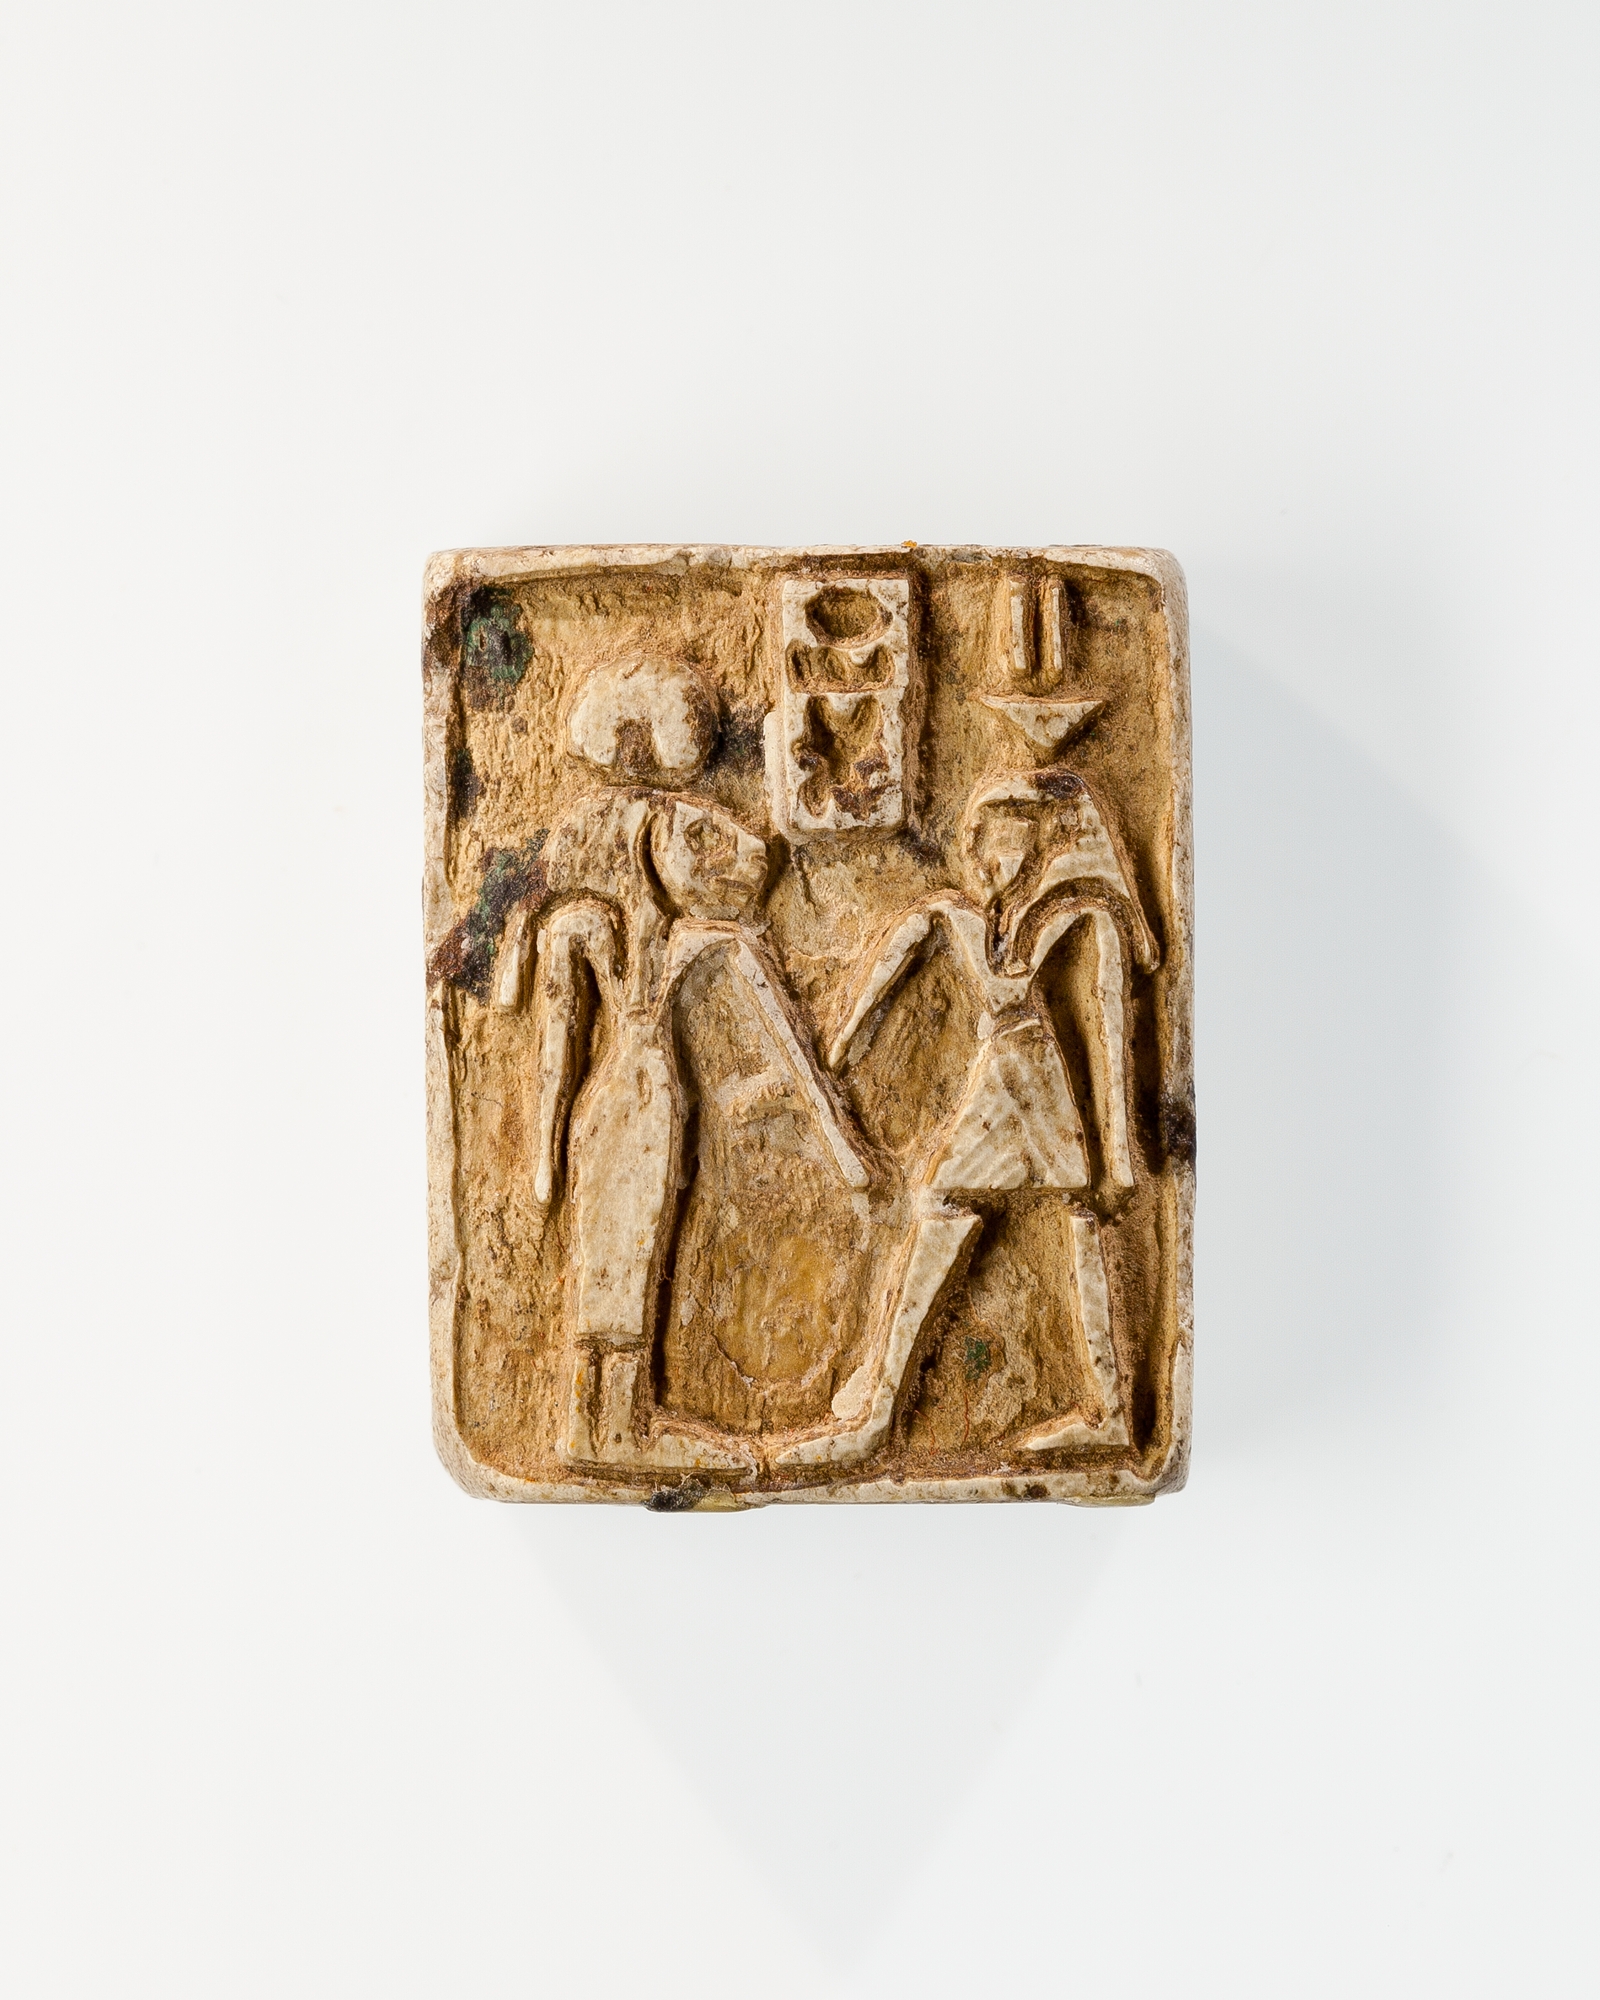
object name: plaque, sakhmet, nefertum, horse rider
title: Plaque: side 1, Sakhmet and Nefertum on either side of the name Menkheperre (Thutmose III); side 2, rider and trampled captive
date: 1295-1070 BCE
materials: stone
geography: egypt